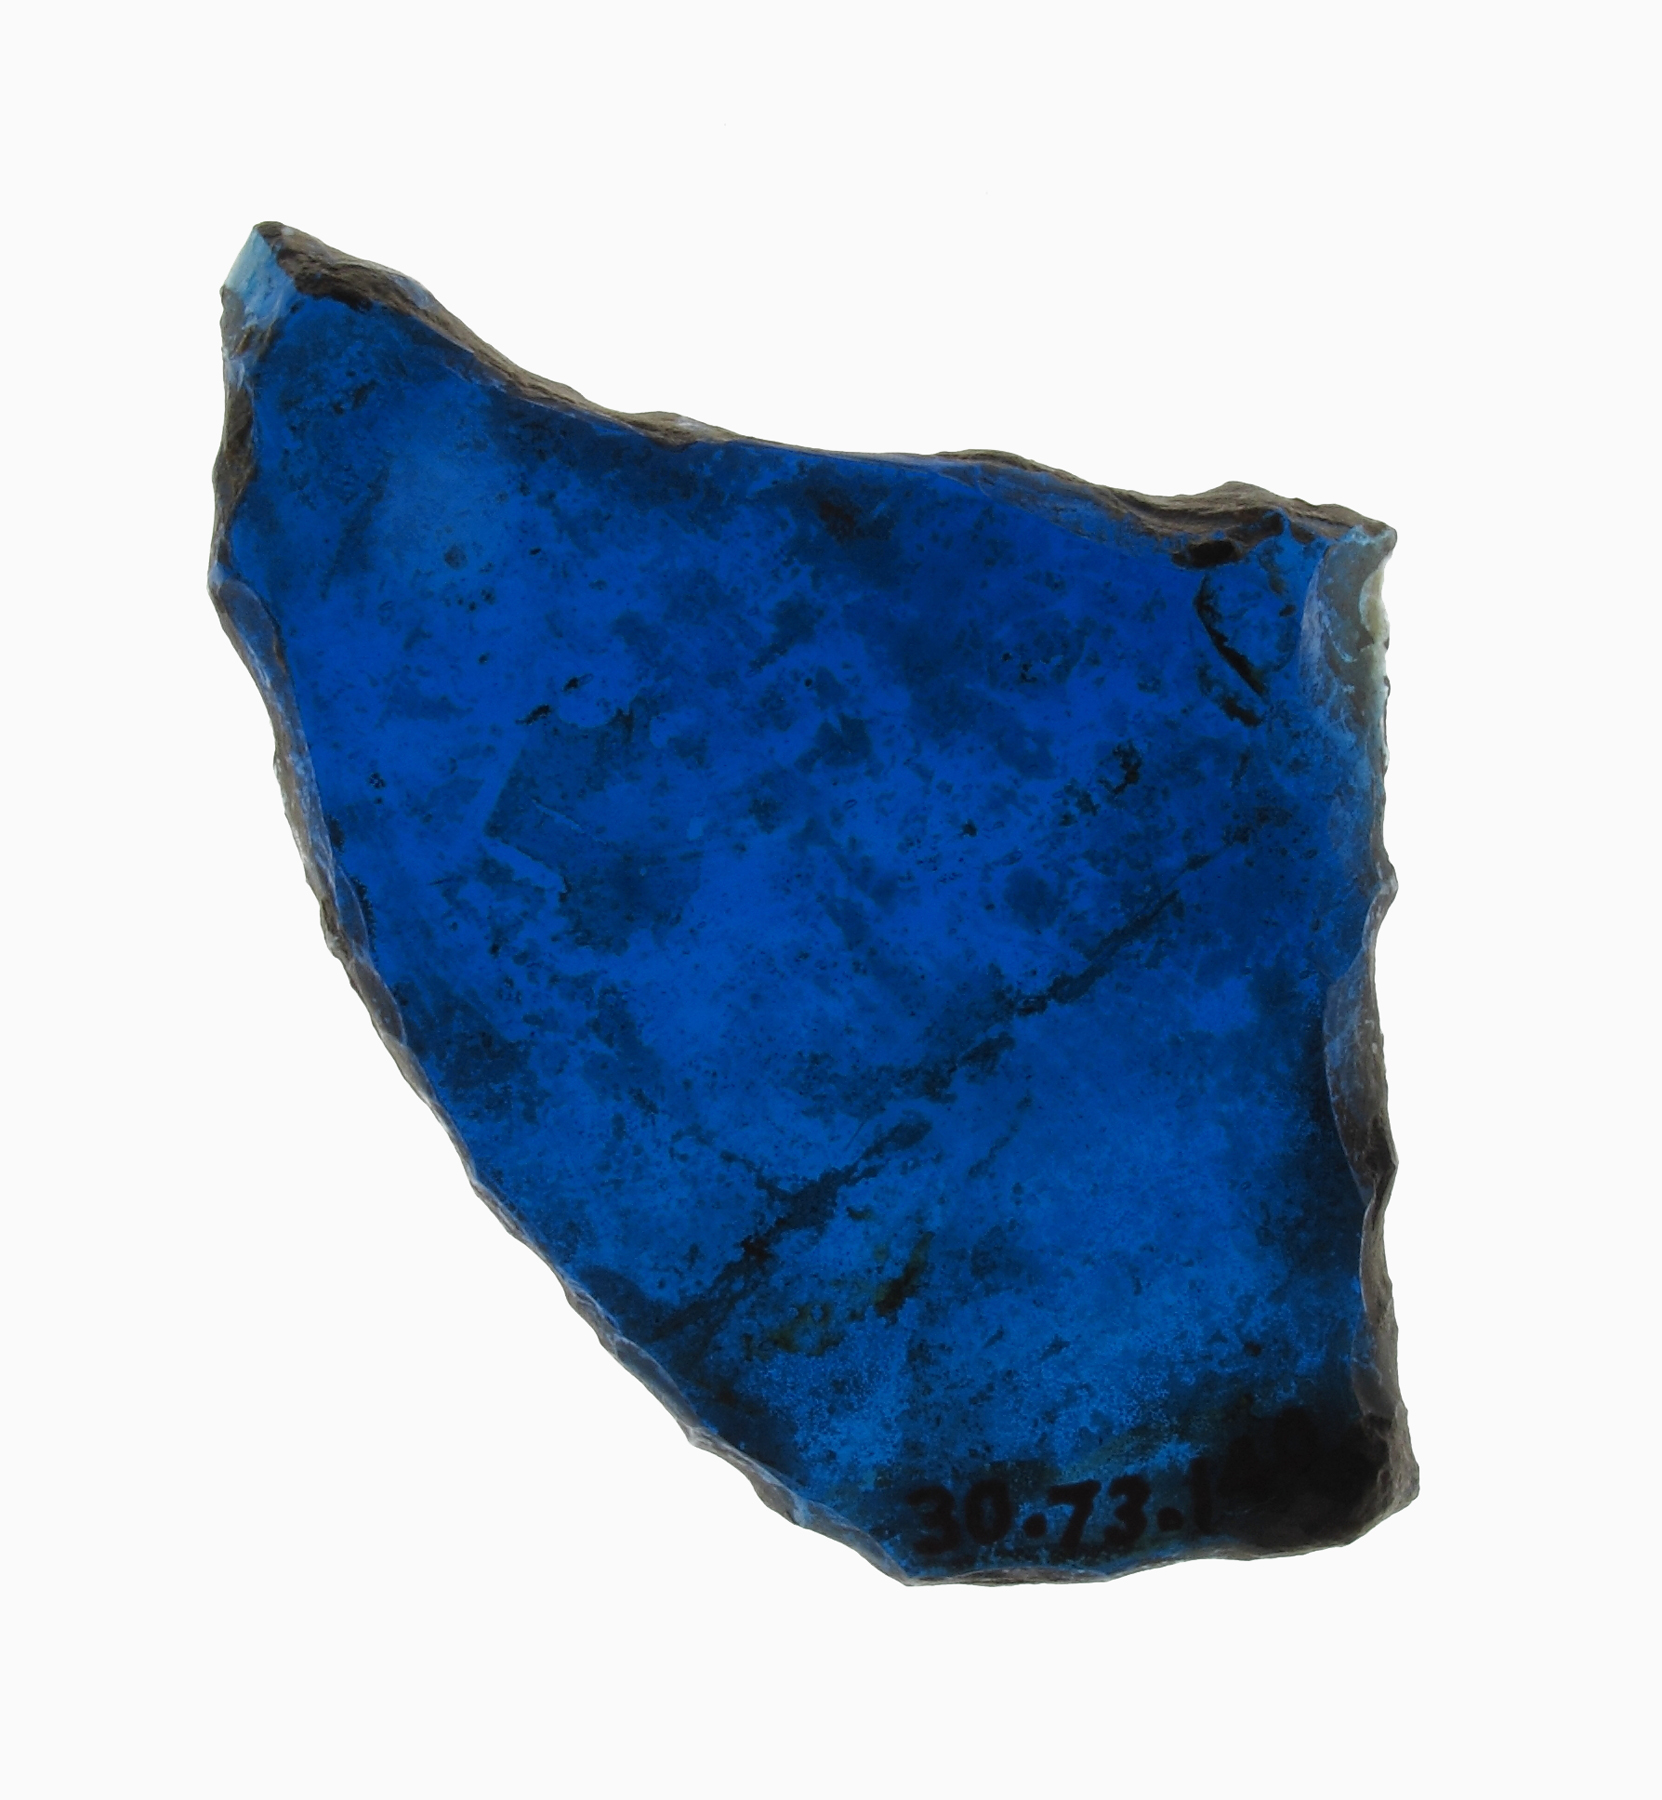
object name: fragment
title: Glass Fragment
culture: european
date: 1201-1400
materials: glass, metal